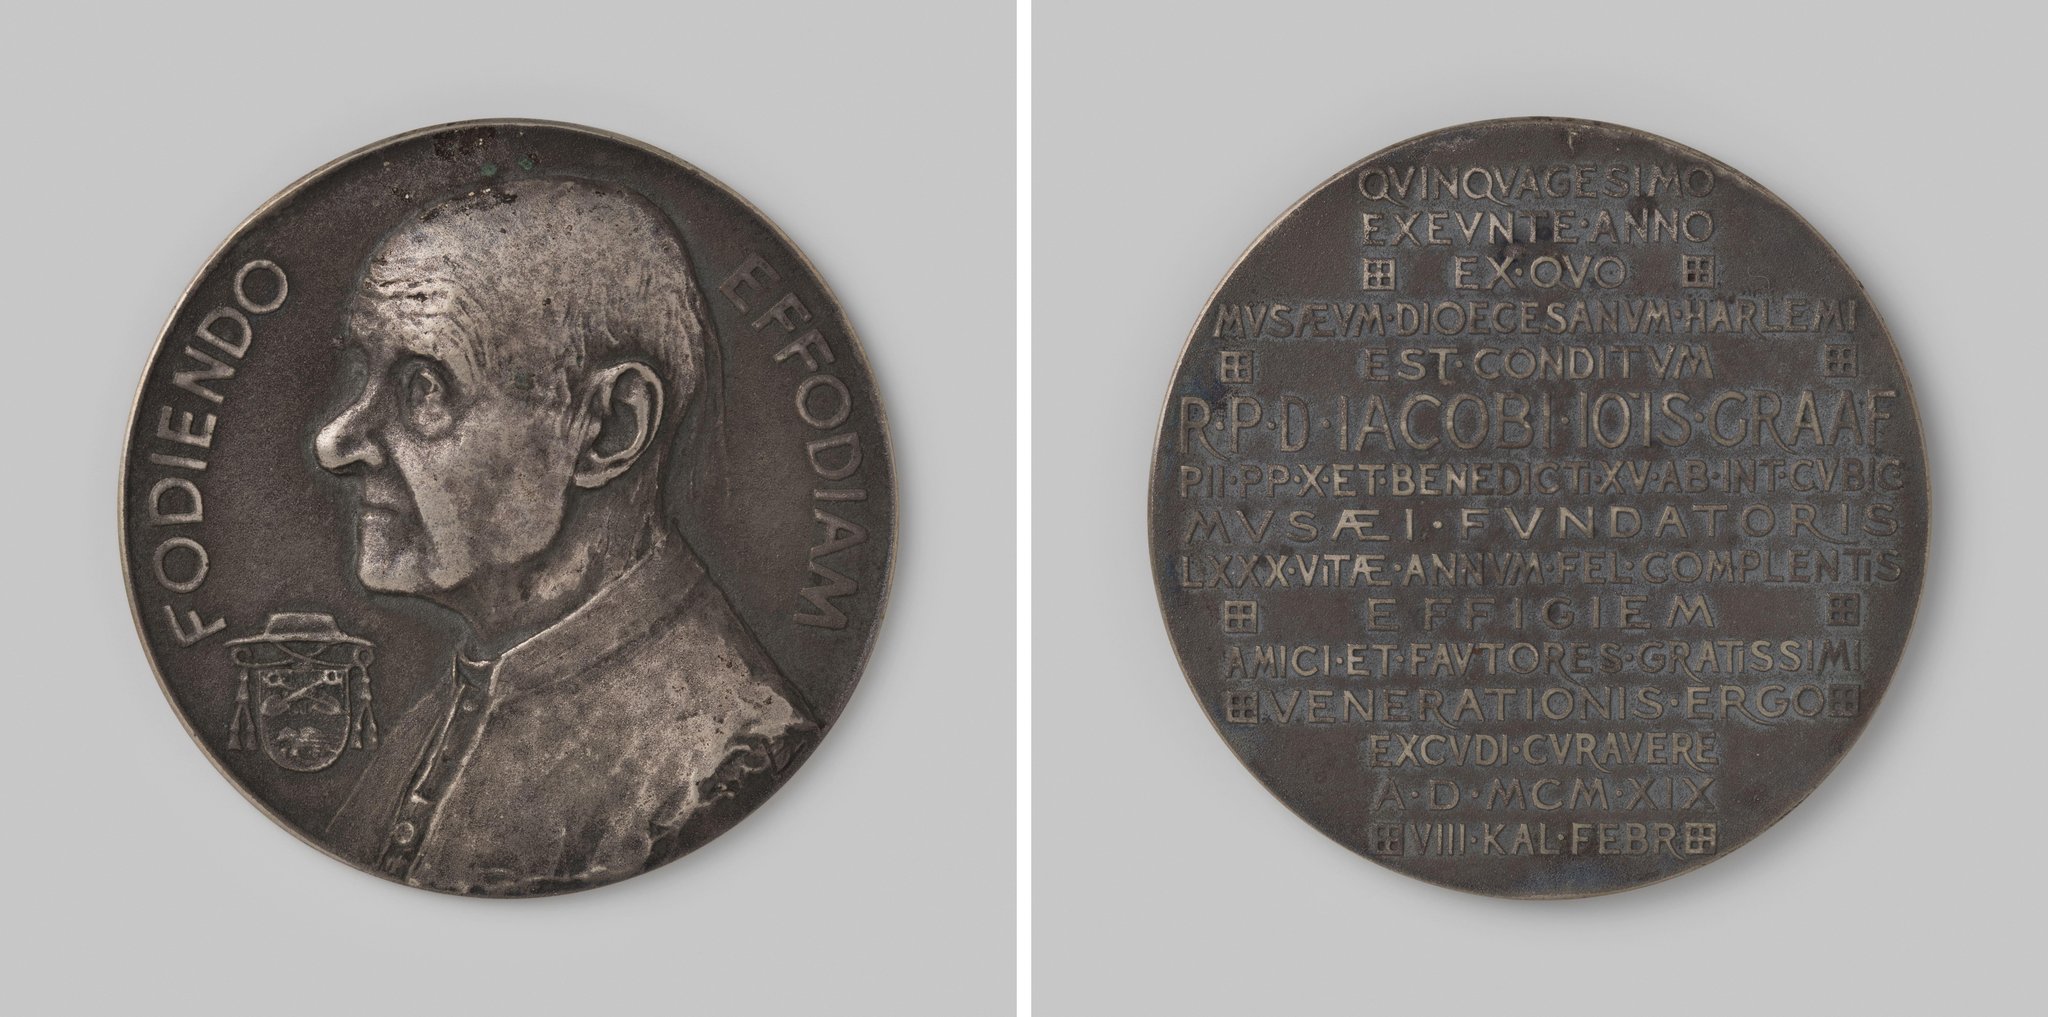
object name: history medal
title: Tachtigste verjaardag van J.J. Graaf, oprichter van het Bisschoppelijk Museum te Haarlem 1919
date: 1919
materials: silver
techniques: casting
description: Grote gegoten zilveren penning, op de voorzijde het borstbeeld van Graaf naar links naast zijn familiewapen, met omschrift, op de keerzijde vijftien regels latijnse tekst.